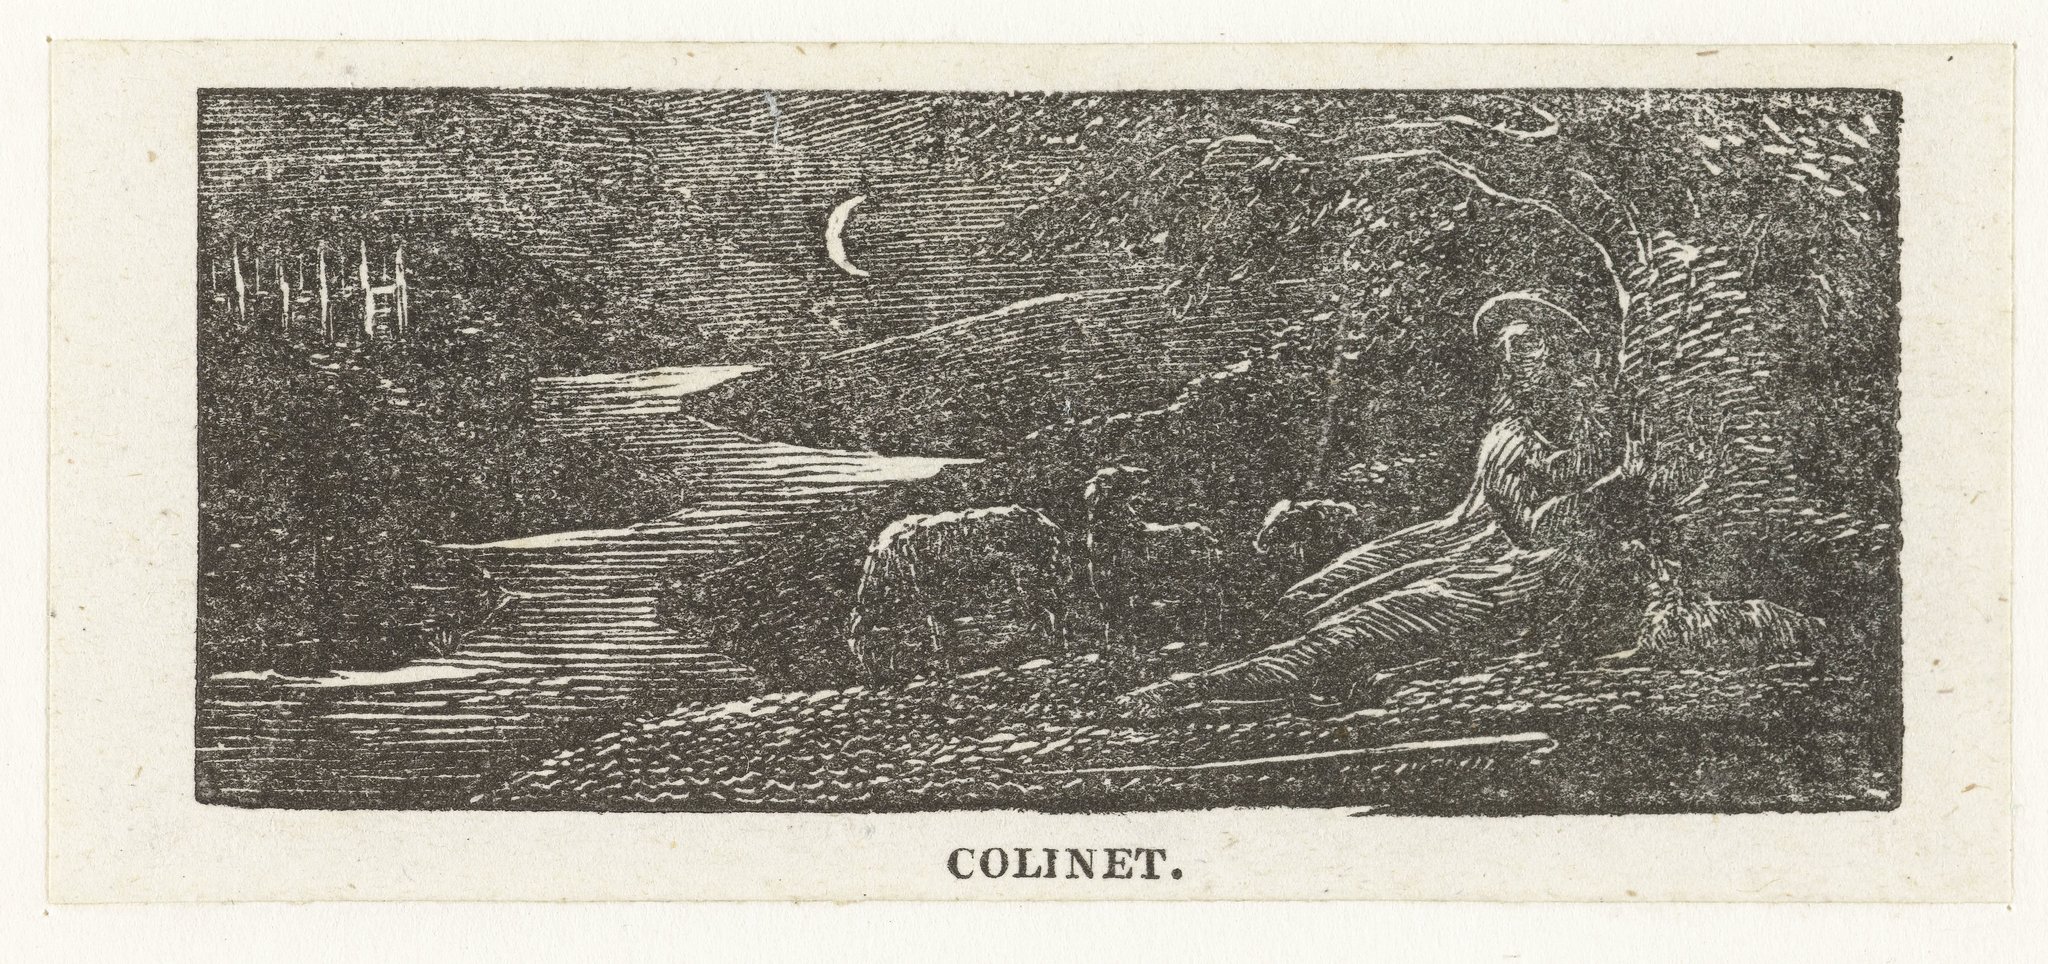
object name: book illustration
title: Colinet rust tijdens de nacht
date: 1820-1821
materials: paper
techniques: engraving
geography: england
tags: illustration ~ printed matter, book, night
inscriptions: inscription: ‘Colinet’, collector's mark: Lugt 2228, collector's mark: Lugt 2760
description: Illustratie uit "Imitations of Ecologue I", de achttiende-eeuwse imitatie van de eerste Ecloge van Vergilius, geschreven door Ambrose Philips, waarin twee herders Thenot and Colinet met elkaar converseren. De prent maakt deel uit van een serie houtgravures die als illustratie was bedoeld voor het schoolboek "The Pastorals of Virgil", uitgegeven in 1821. De opdracht voor deze prenten is gegeven door Dr R.J. Thornton. Botke, K.